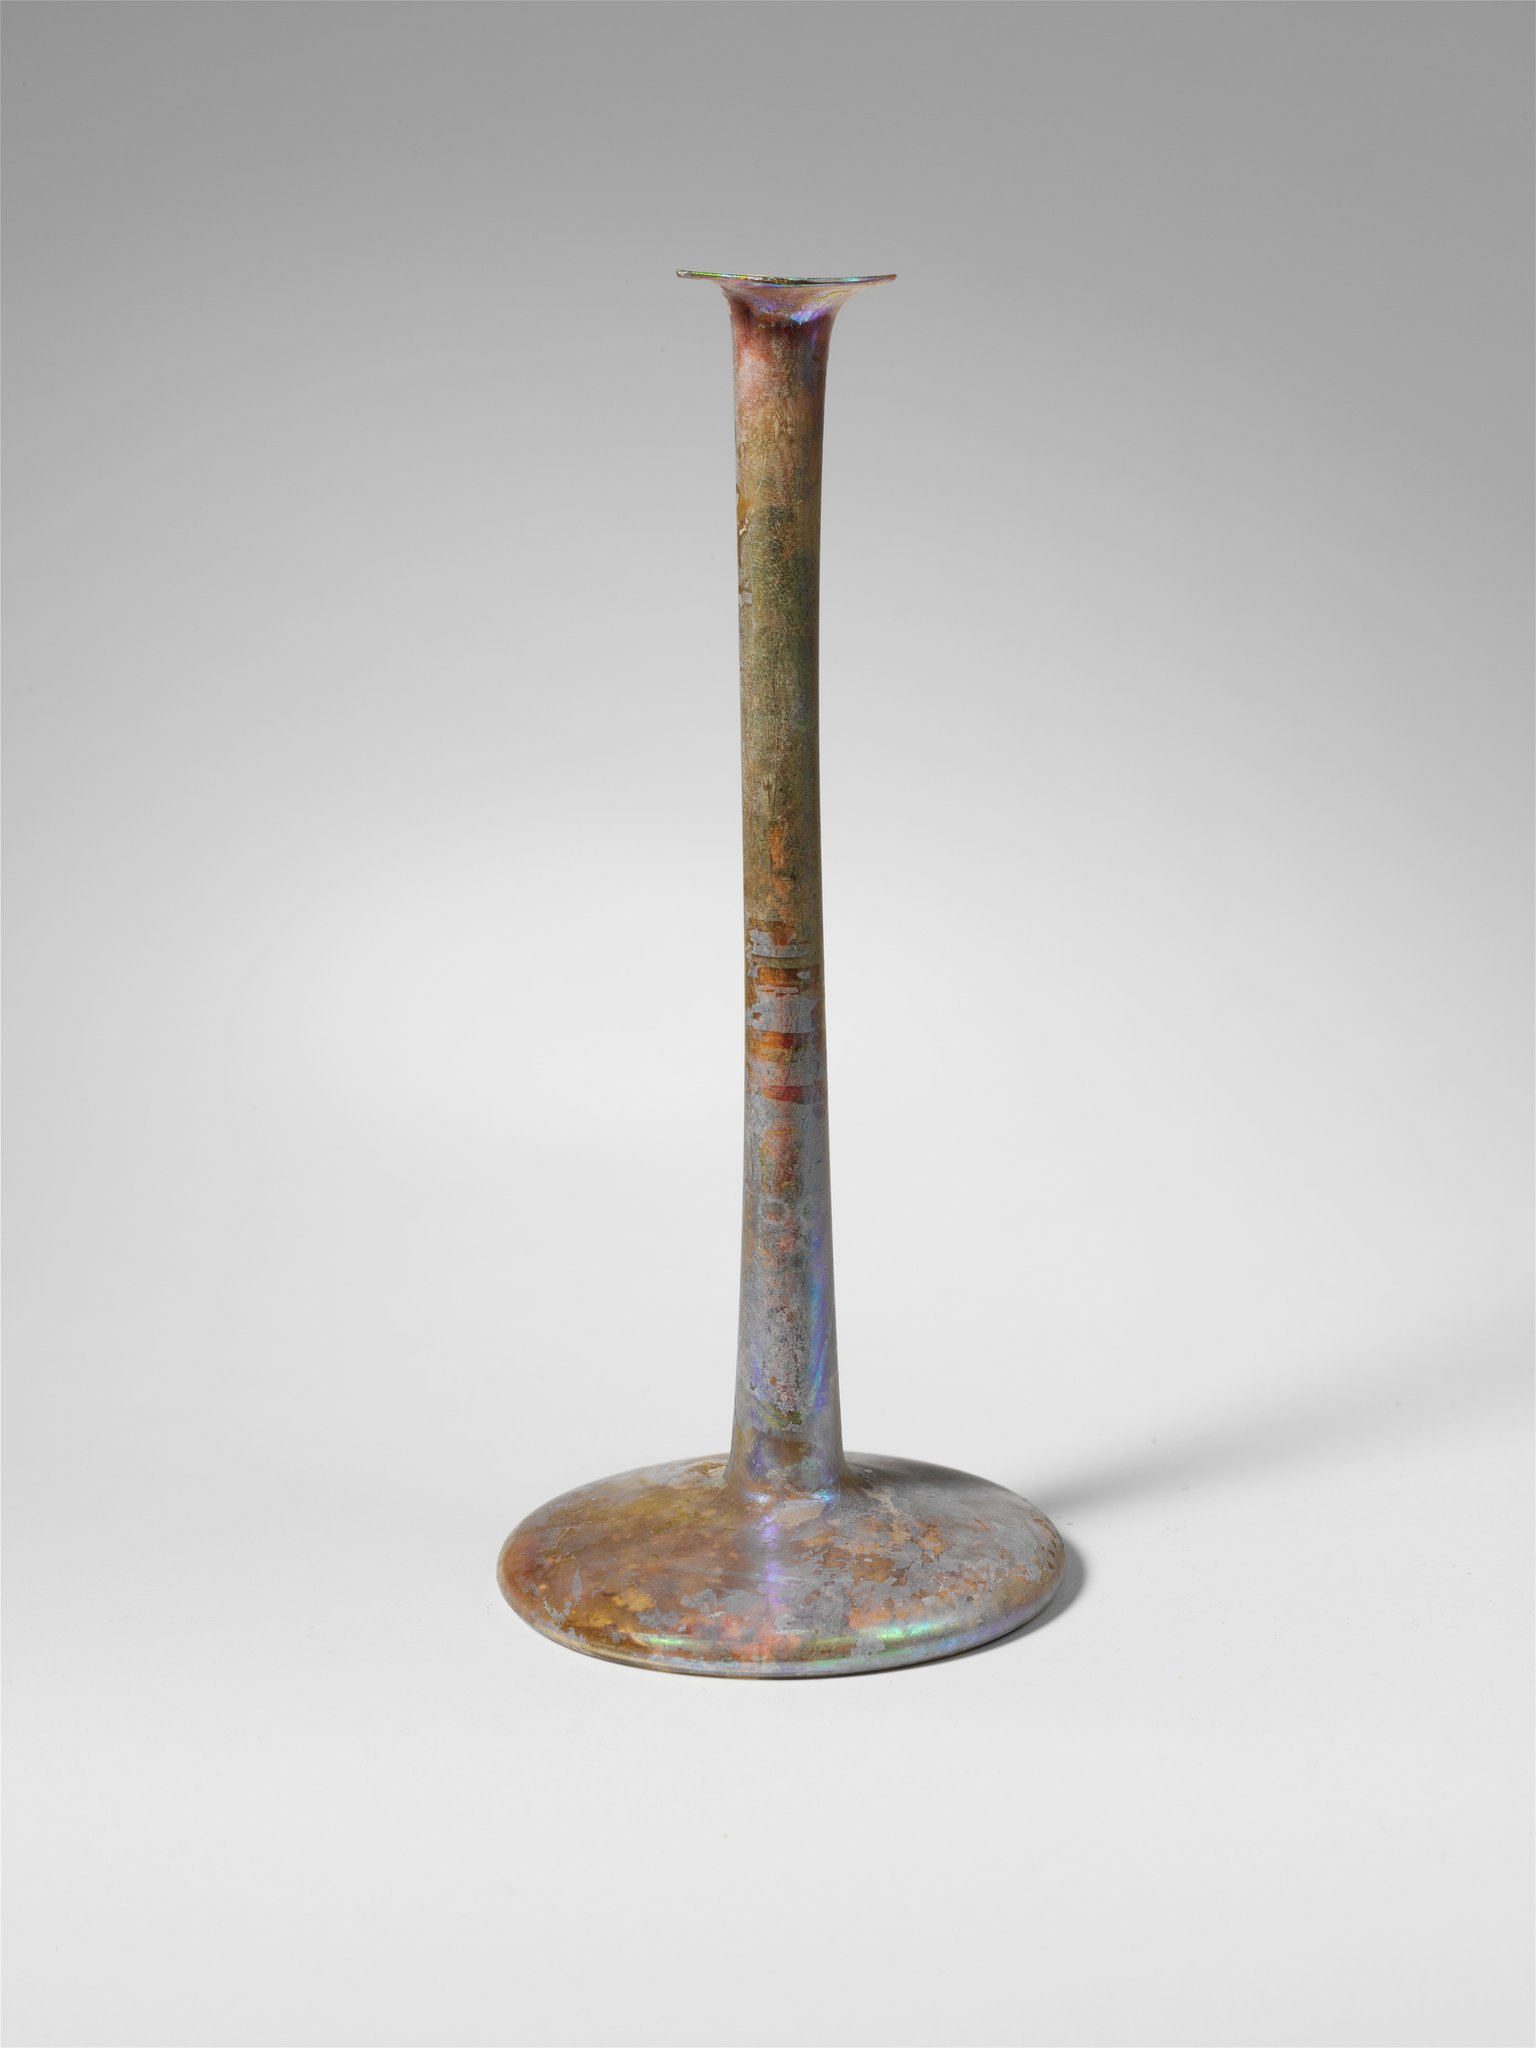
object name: candlestick perfume bottle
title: Glass perfume bottle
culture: roman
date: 101-300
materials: glass